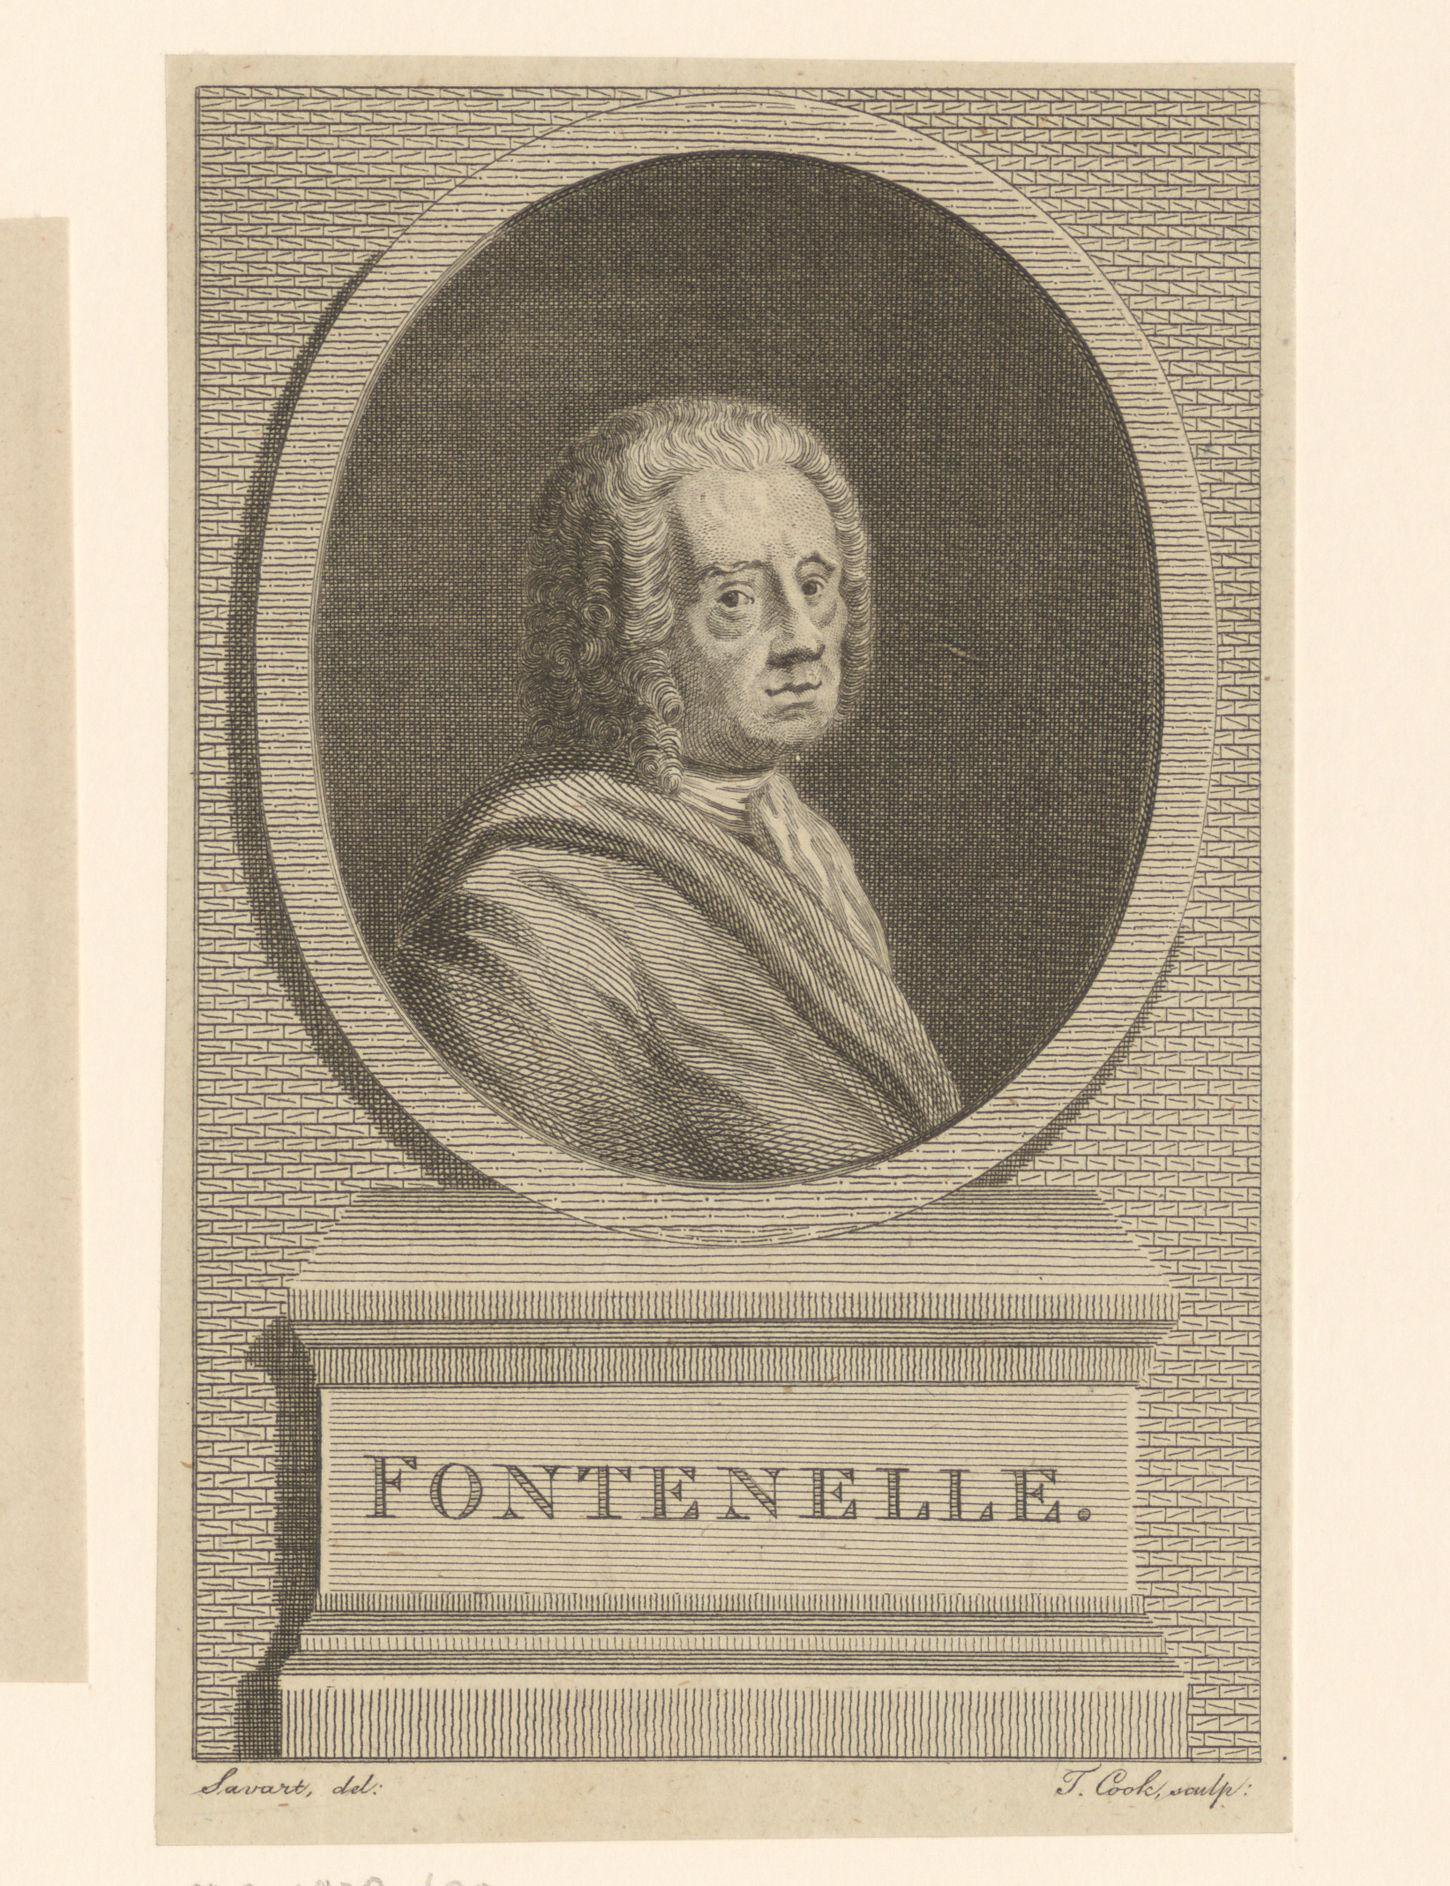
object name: print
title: Portret van Bernard Le Bovier de Fontenelle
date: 1754-1818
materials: paper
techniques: engraving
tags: paris, historical persons, scholar, philosopher (+ portrait of scholar, scientist)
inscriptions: collector's mark: Lugt 2228